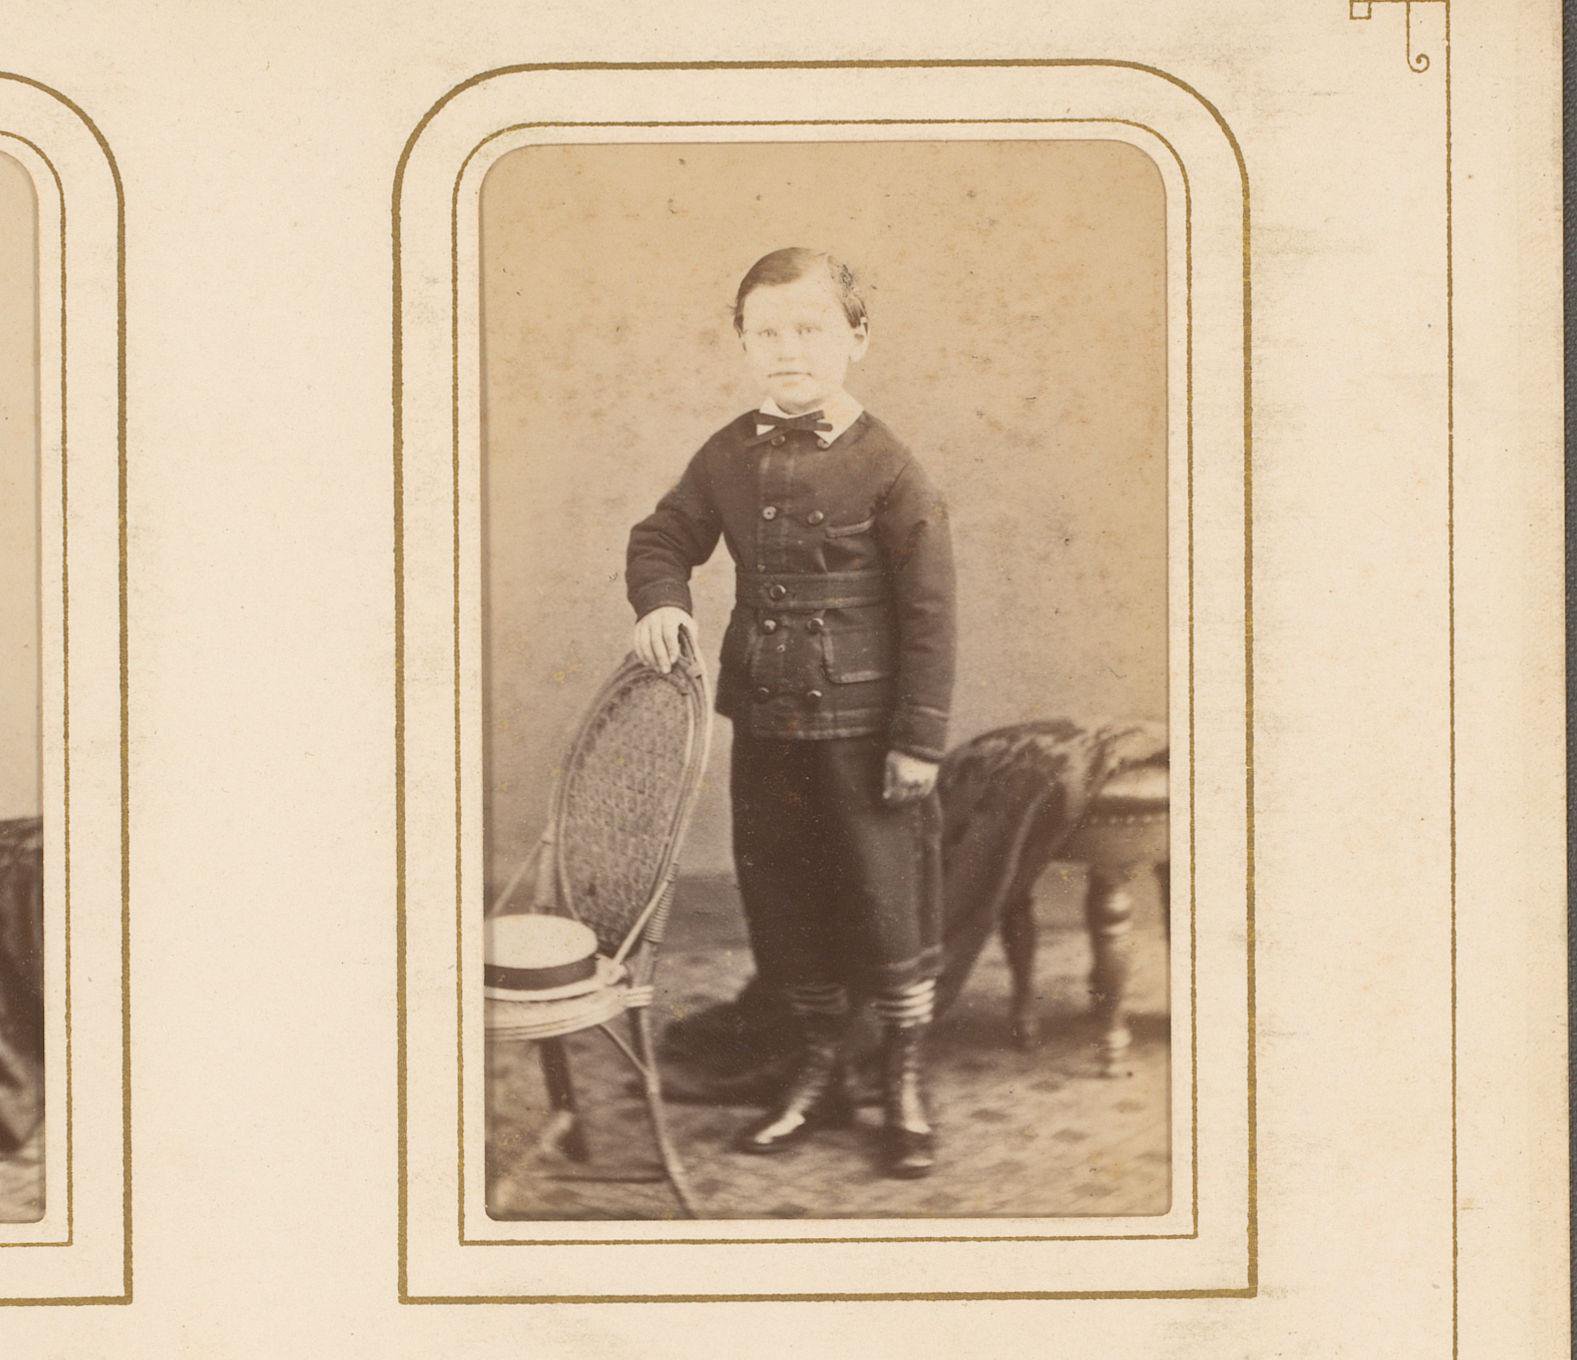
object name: carte de visite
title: Portret van een jongen, staand bij een stoel met hoed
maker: prosper bevierre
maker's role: fotograaf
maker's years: 1822-1893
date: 1850-1893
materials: cardboard, photographic support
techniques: albumen print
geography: charleroi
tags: boy (child between toddler and youth), historical persons, head-gear: hat, chair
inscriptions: inscription: ‘P. BEVIERRE/ 3, Rue de la Montagne, 3./ CHARLEROI’